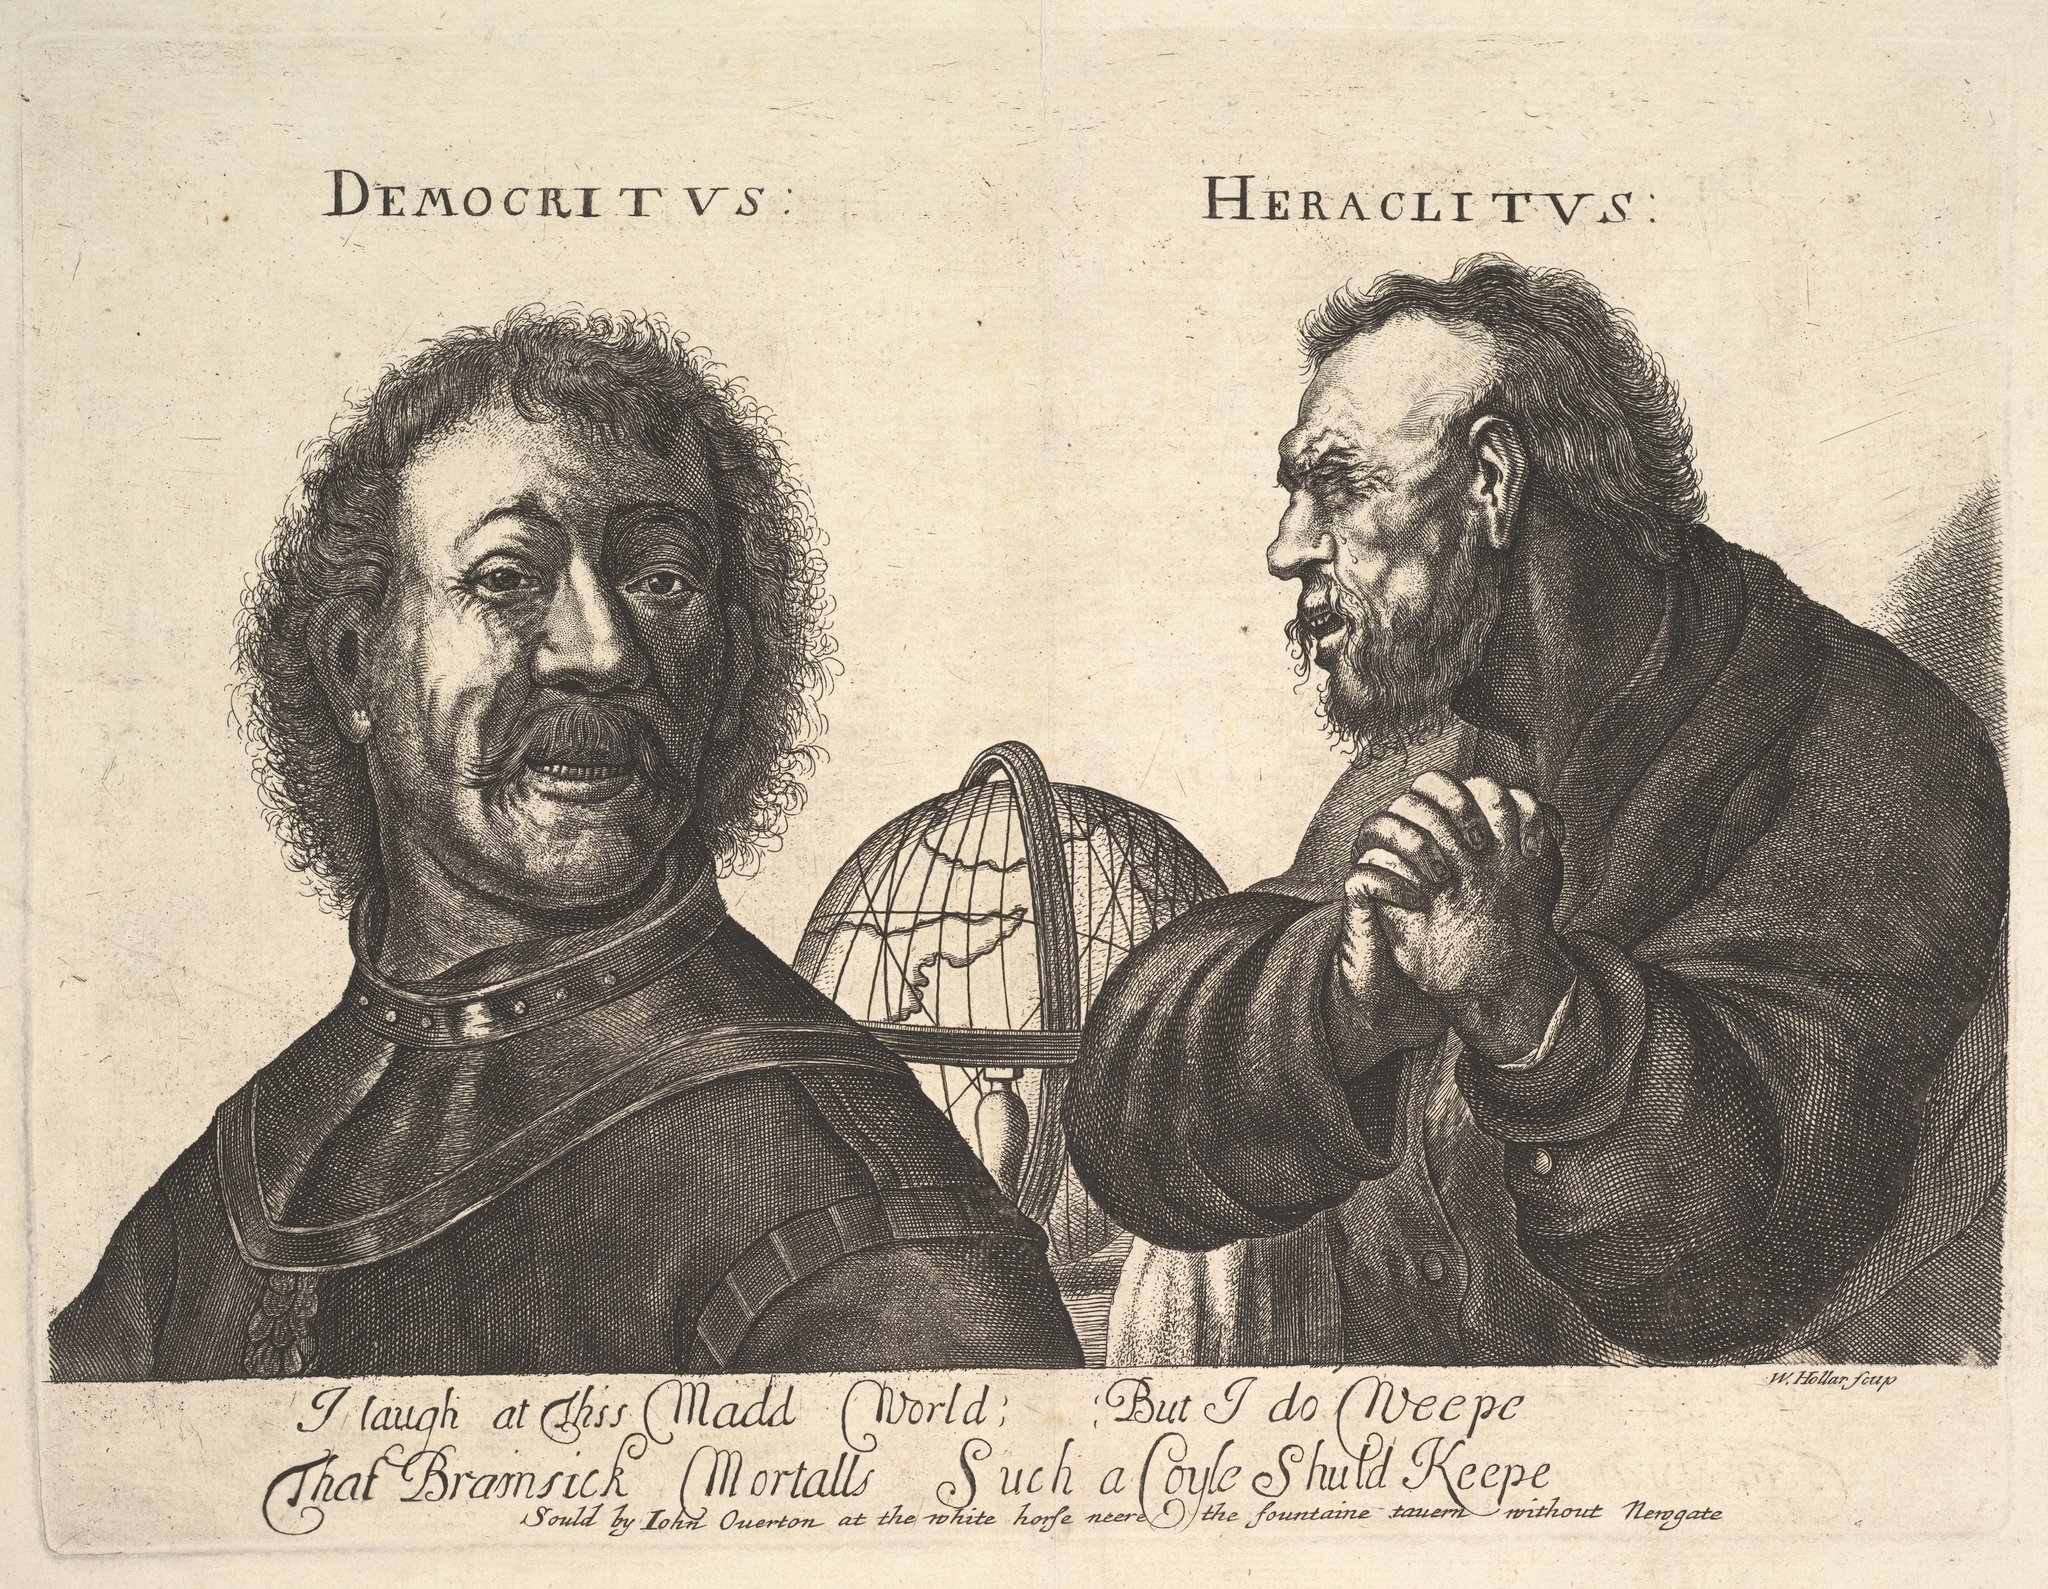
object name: print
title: Democritus and Heraclitus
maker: wenceslaus hollar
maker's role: former attribution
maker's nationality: bohemian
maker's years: 1607-1677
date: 1650-1660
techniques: etching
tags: men,portraits,globes